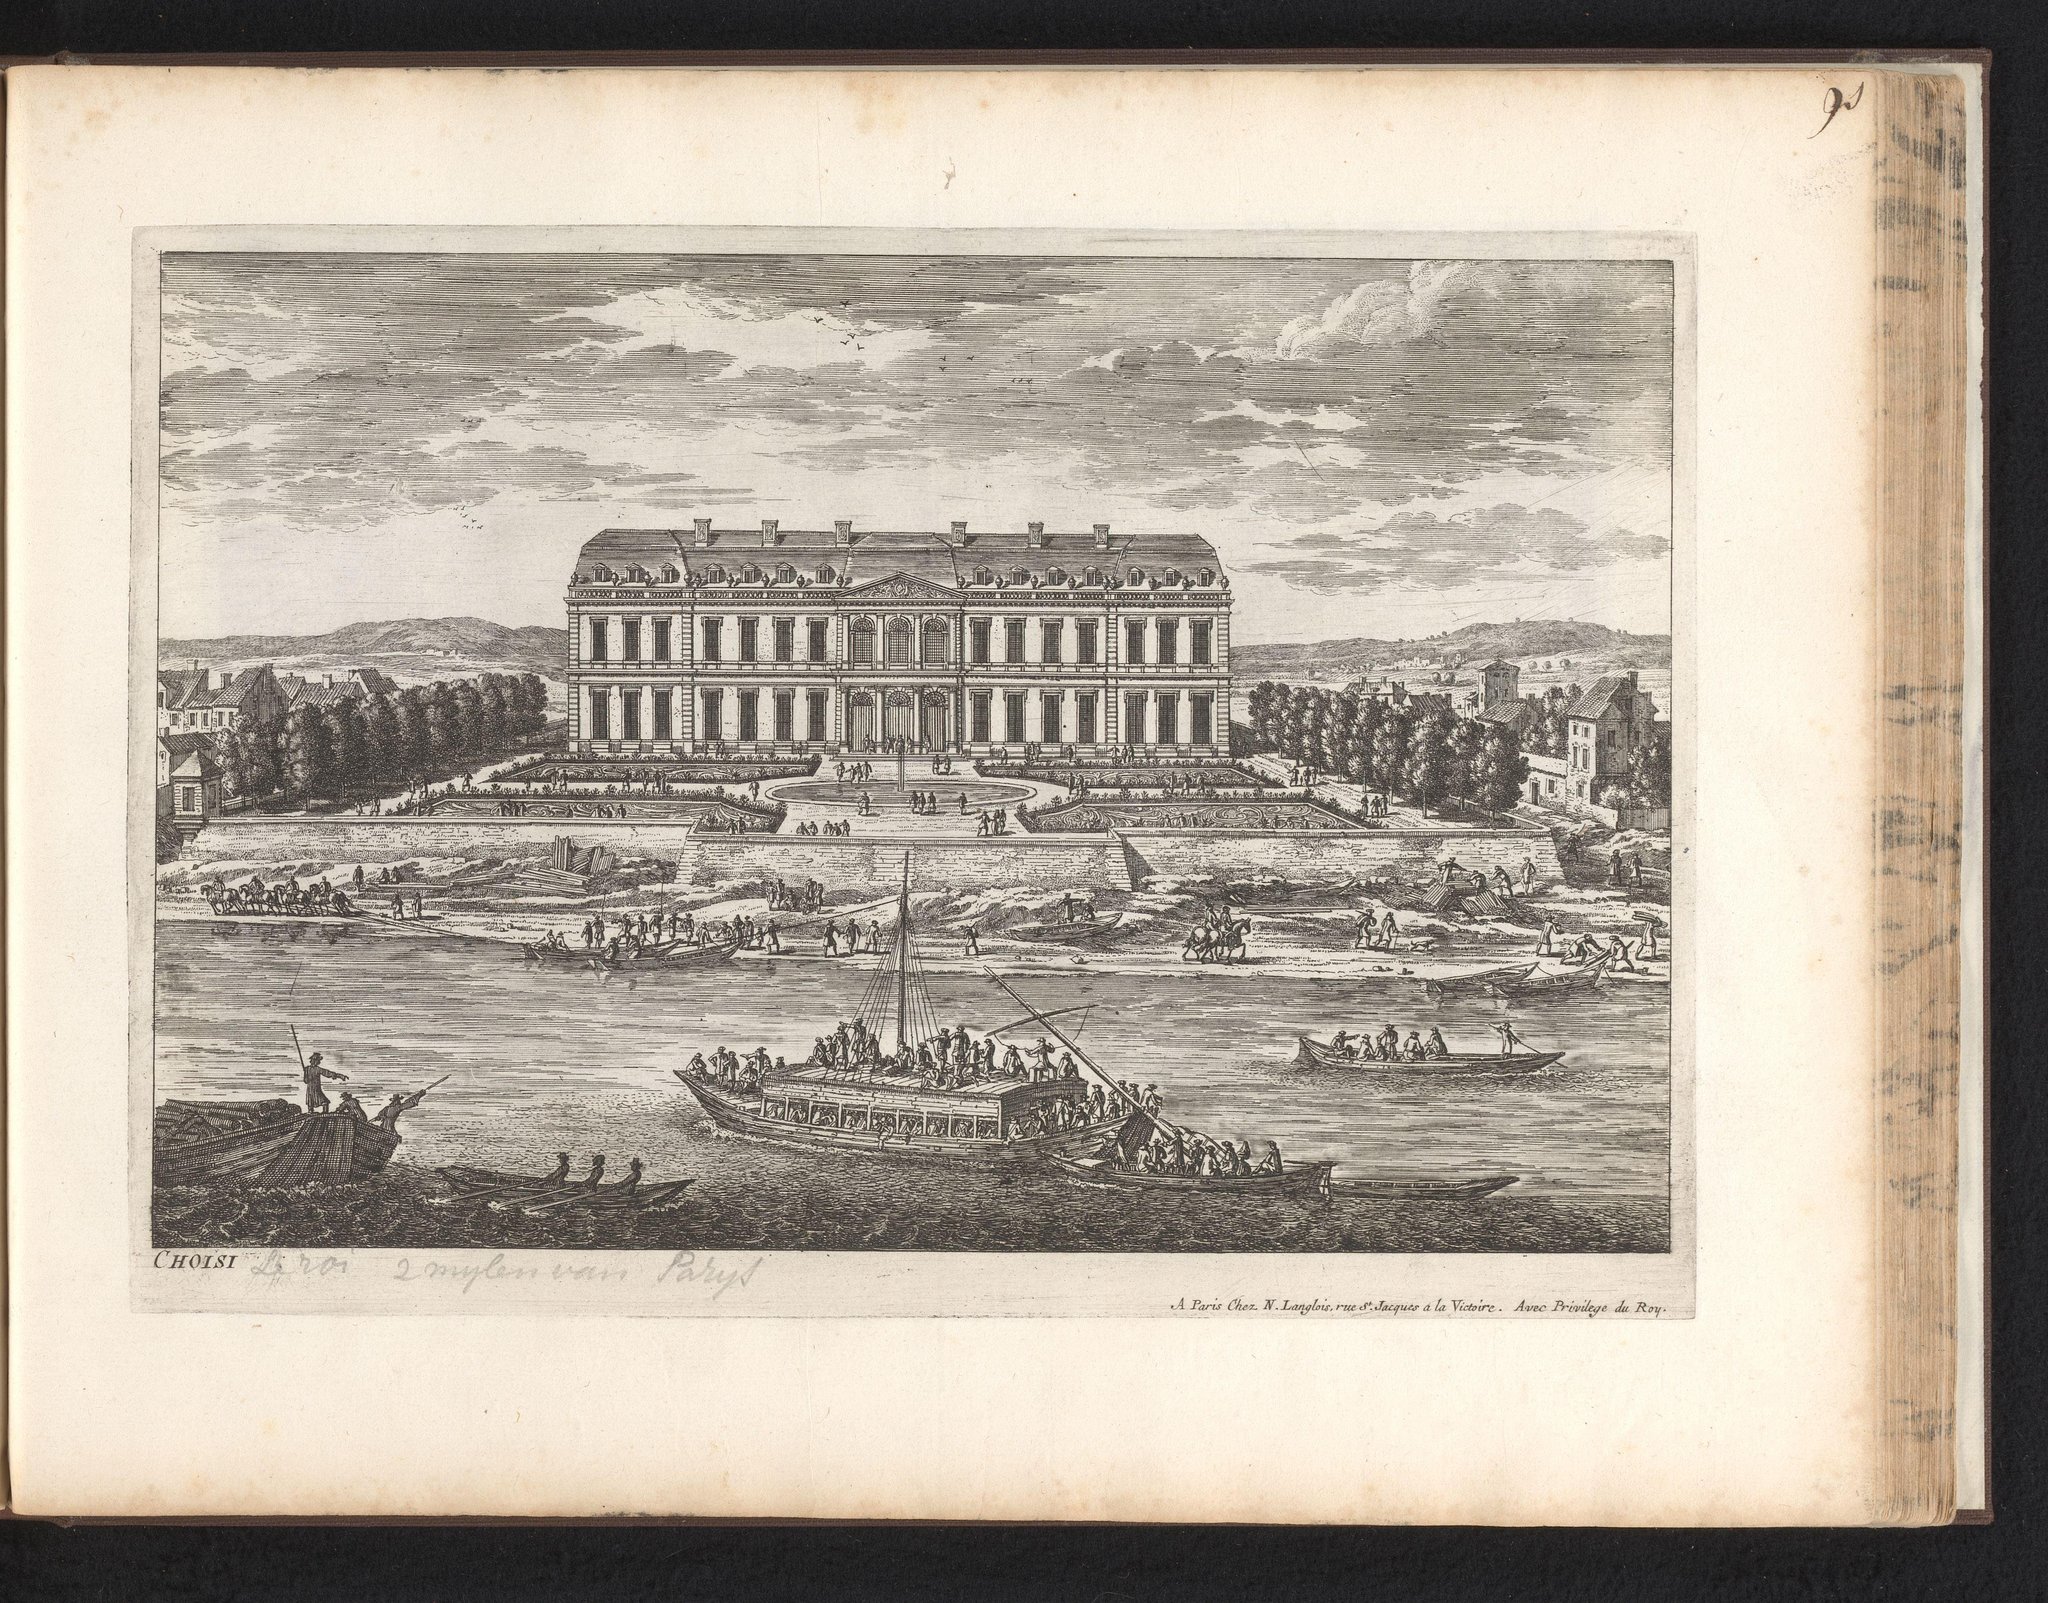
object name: print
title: Stadsgezichten en landschappen in Frankrijk en Italië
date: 1650-1695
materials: paper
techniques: etching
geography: paris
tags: french or architectonic garden; formal garden, landscape with tower or castle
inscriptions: collector's mark: Lugt 2228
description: Prenten met het signatuur 'Perelle' kunnen zowel door vader Gabriel als door zonen Nicolas en Adam gemaakt zijn. De uitgevers vader en zoon Nicolas Langlois worden allebei vermeld als N. Langlois op hetzelfde adres.